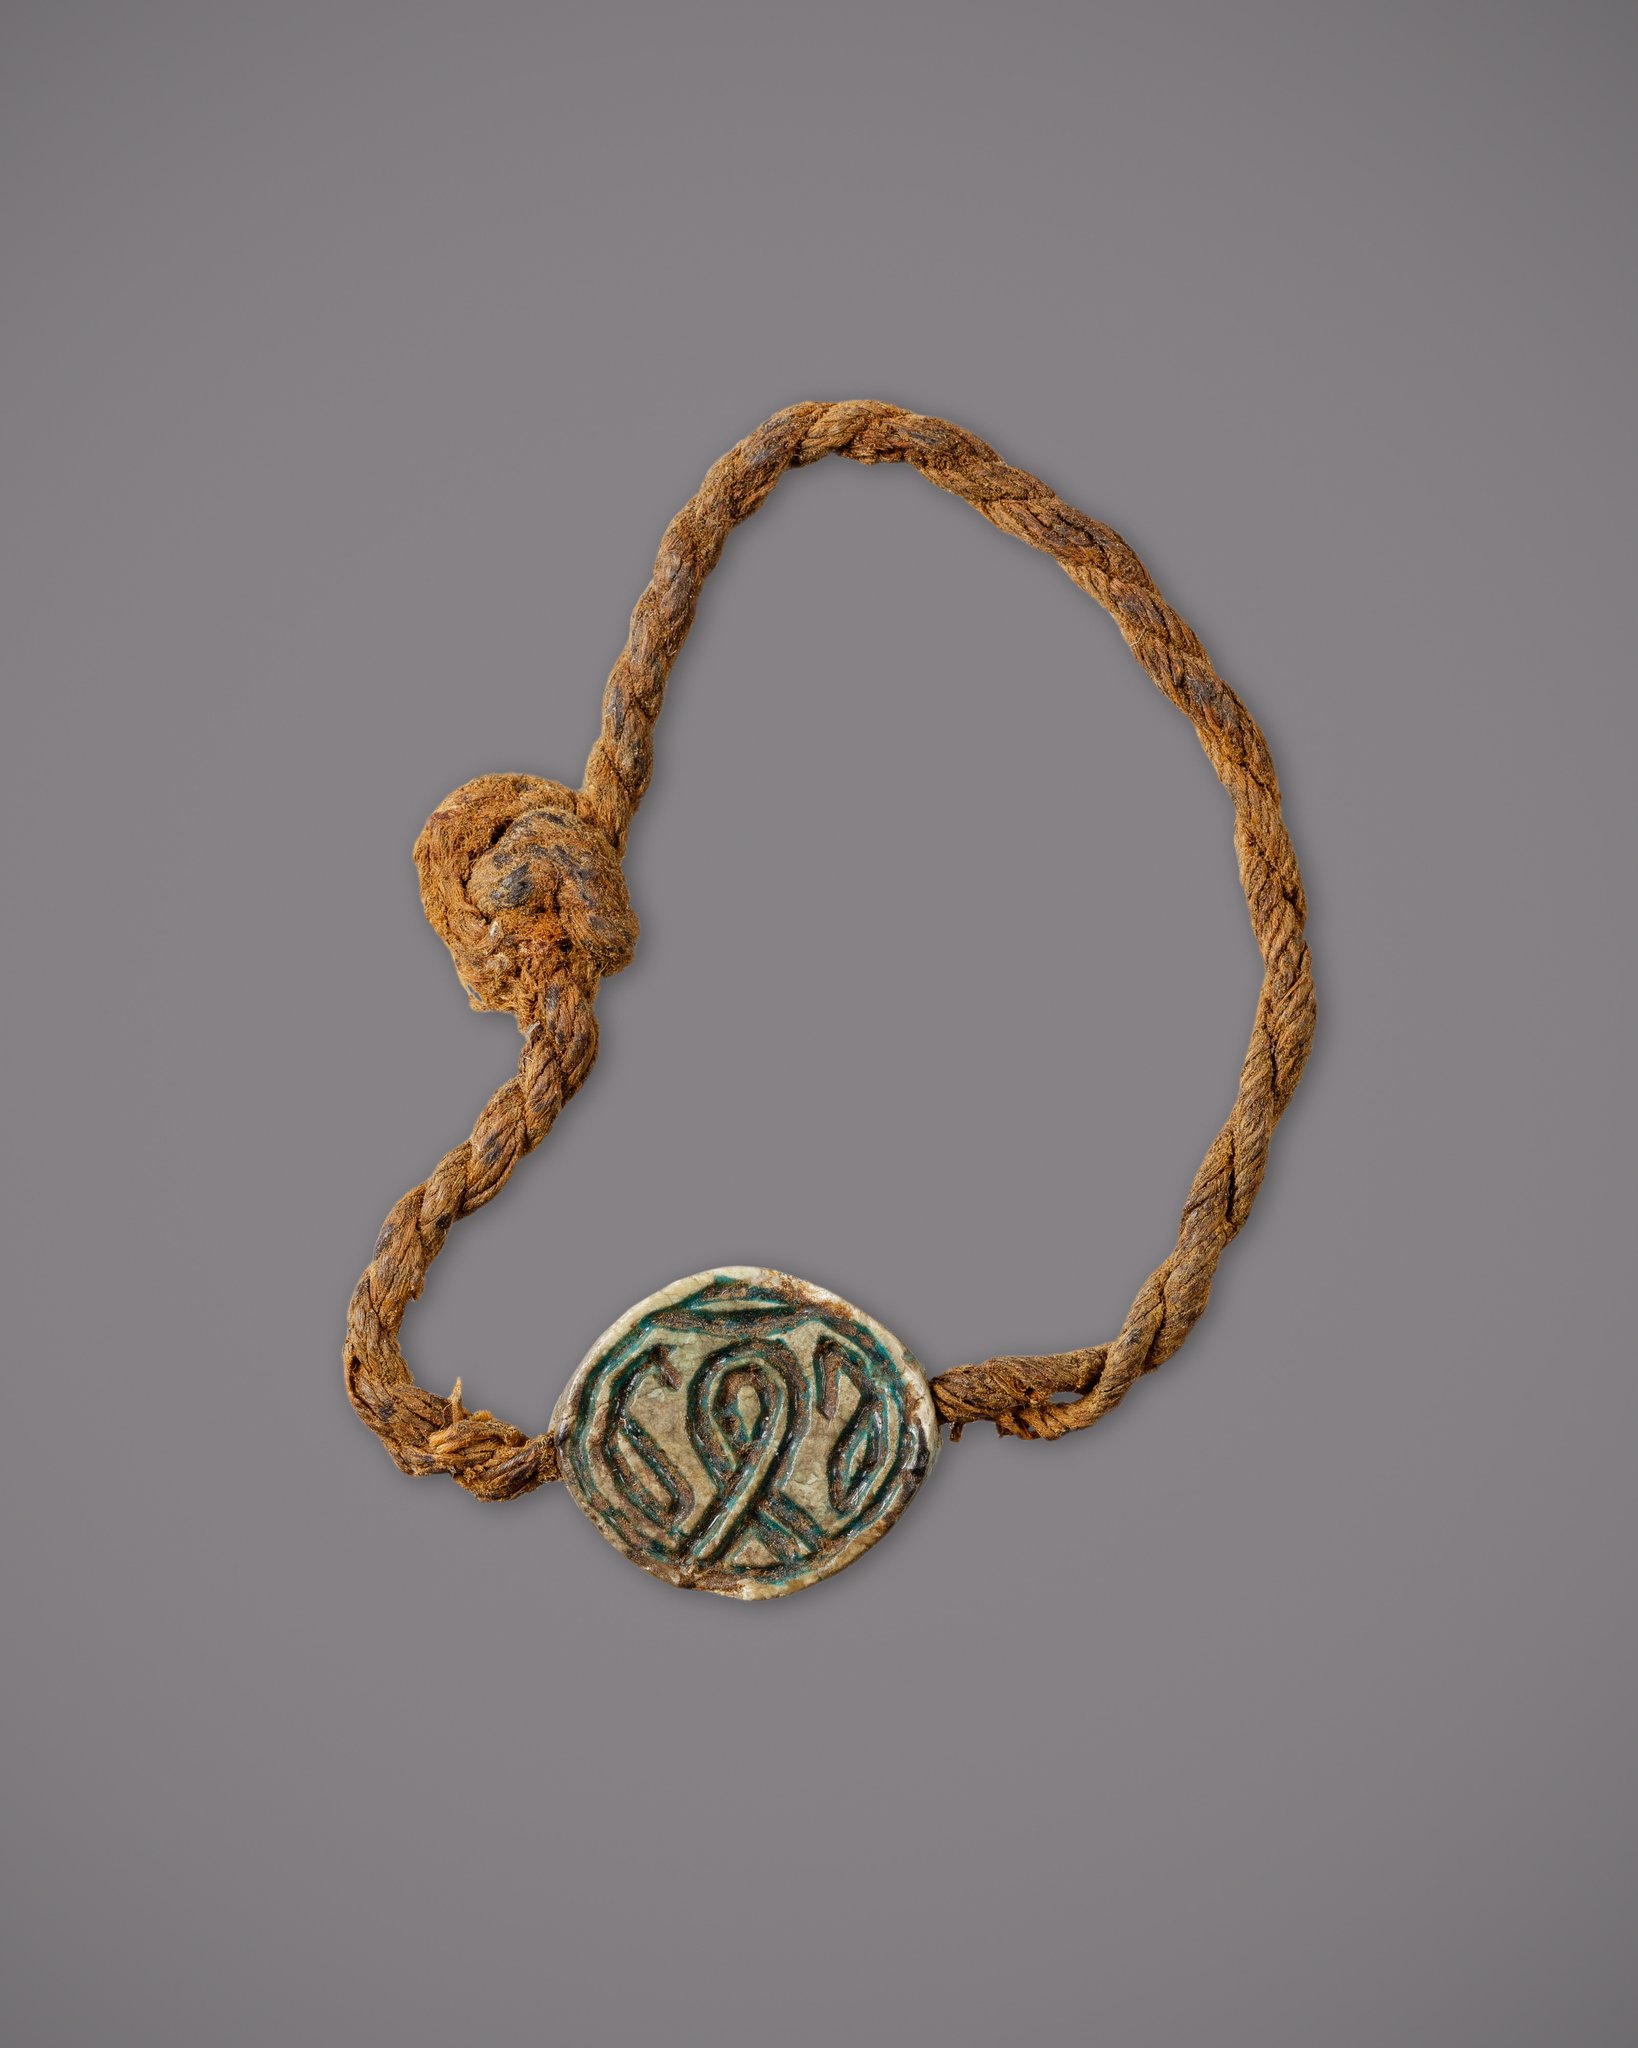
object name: bracelet, cowroid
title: String Bracelet with a Cowroid Amulet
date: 1580-1479 BCE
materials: cord, linen, stone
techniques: glazing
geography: egypt